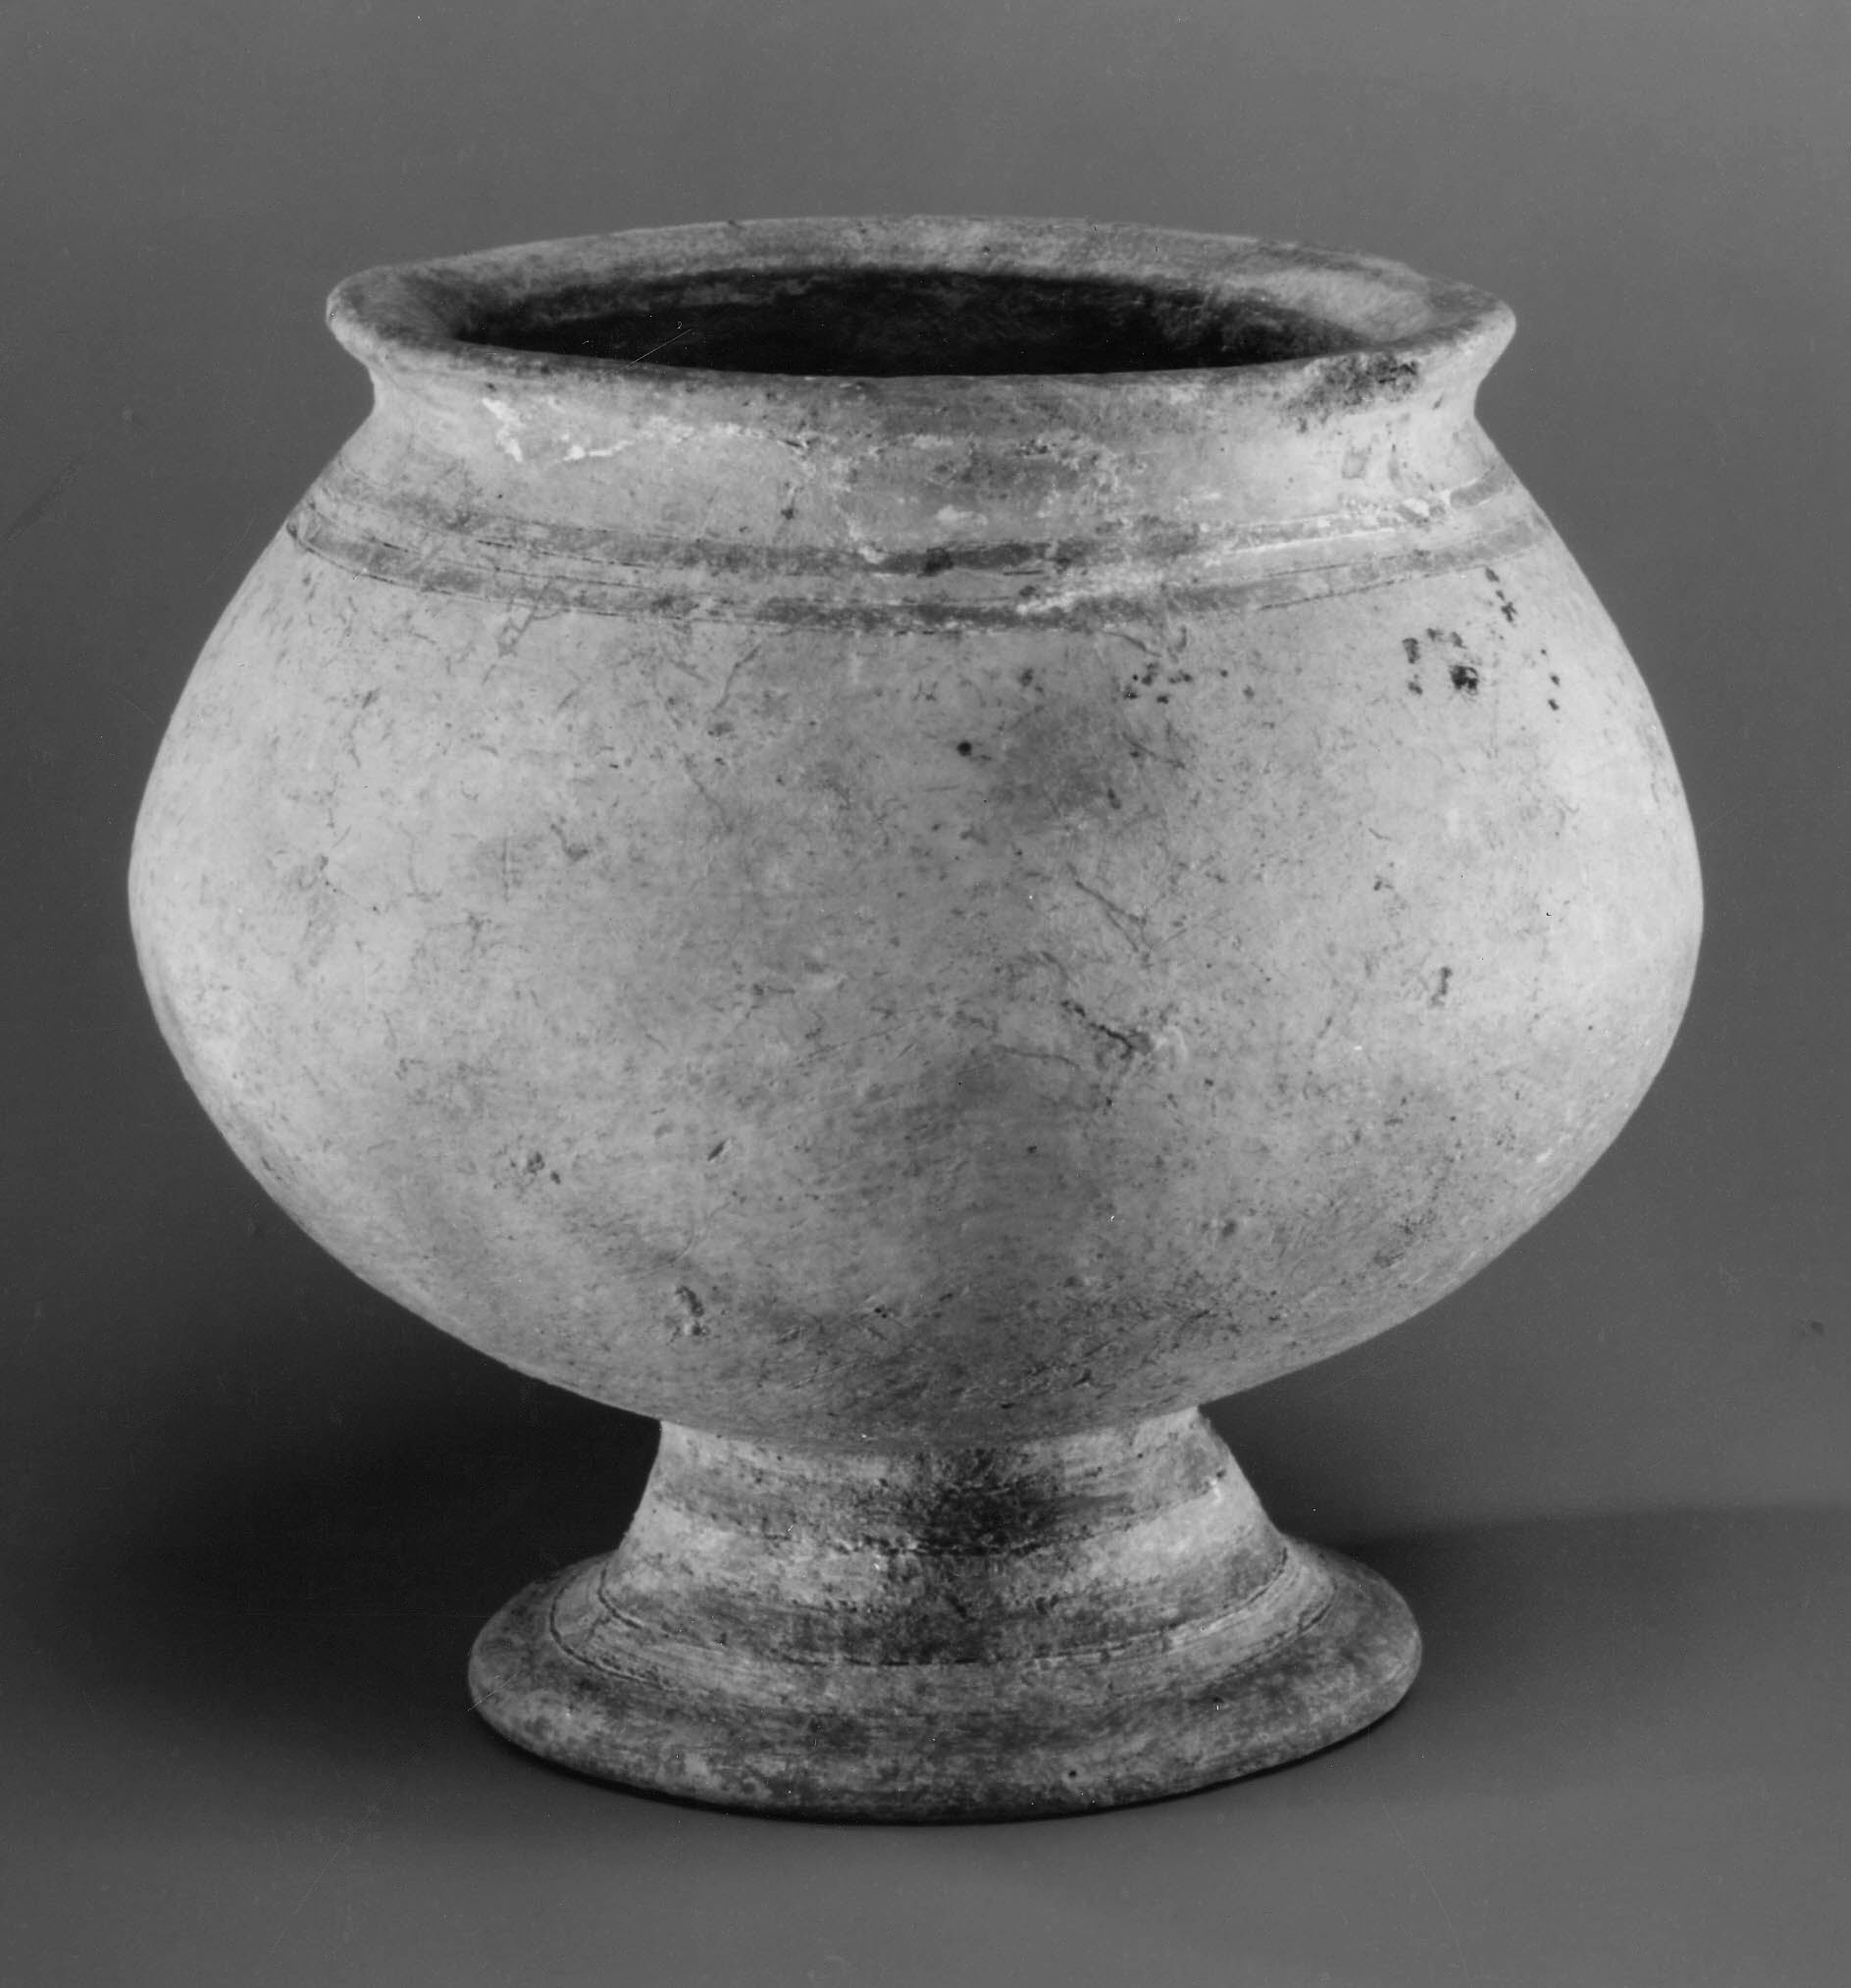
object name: stem bowl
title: Vessel Stem Bowl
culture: thai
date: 1500-1000 BCE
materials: pottery